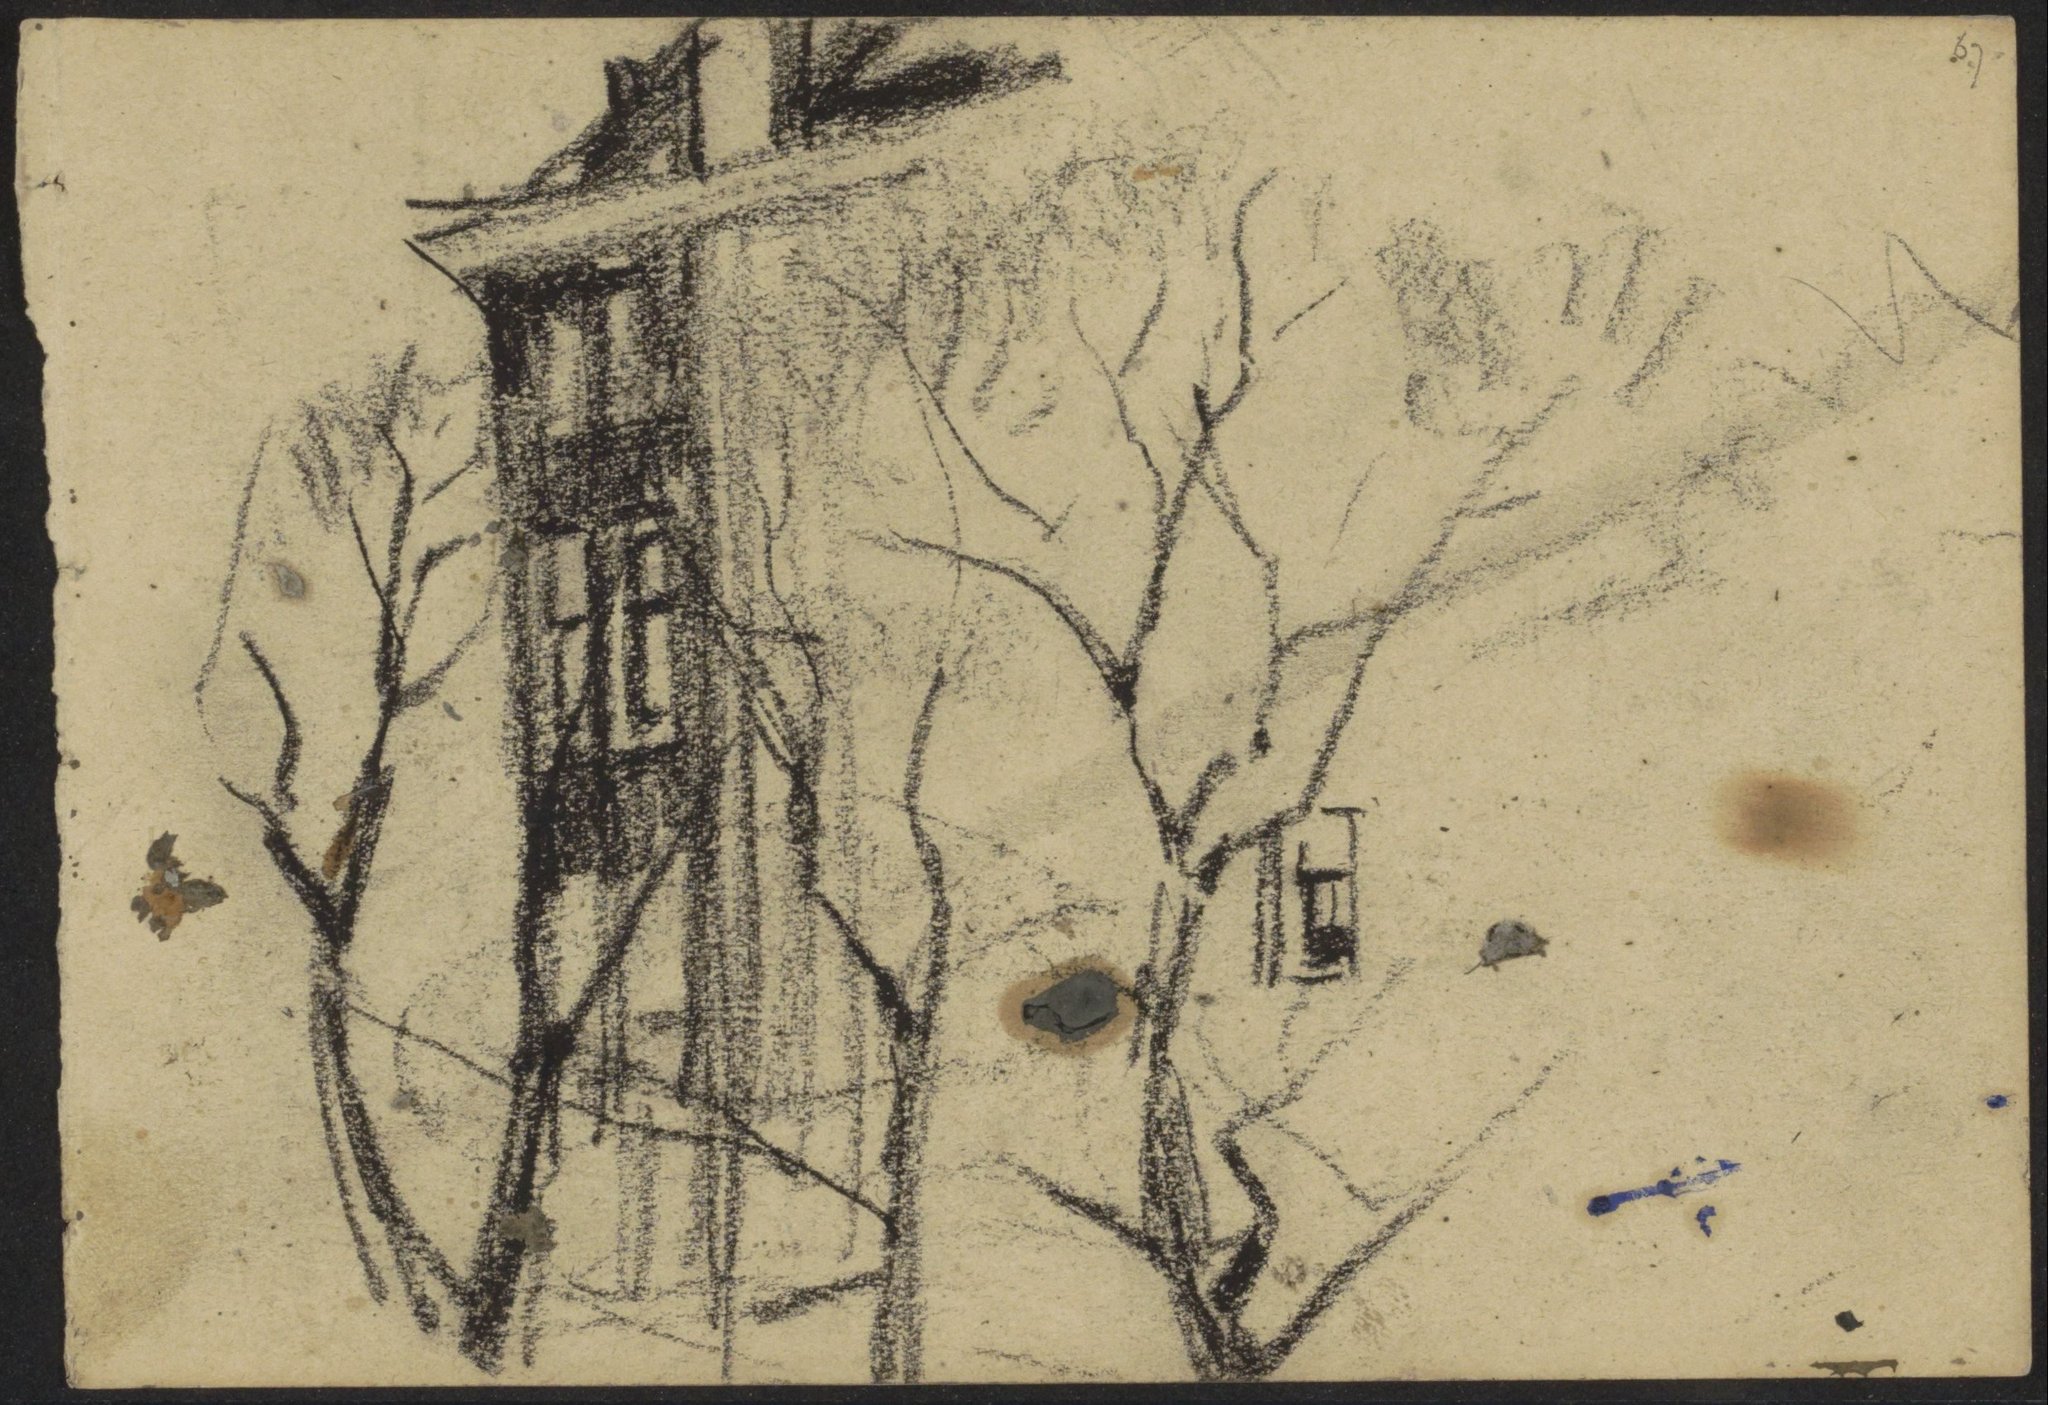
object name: sketchbook leaf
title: Bomen voor een huizenrij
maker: willem witsen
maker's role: draughtsman, painter, print maker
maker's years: 1860-1923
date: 1870-1923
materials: chalk, paper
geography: amsterdam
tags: urban housing, trees, amsterdam